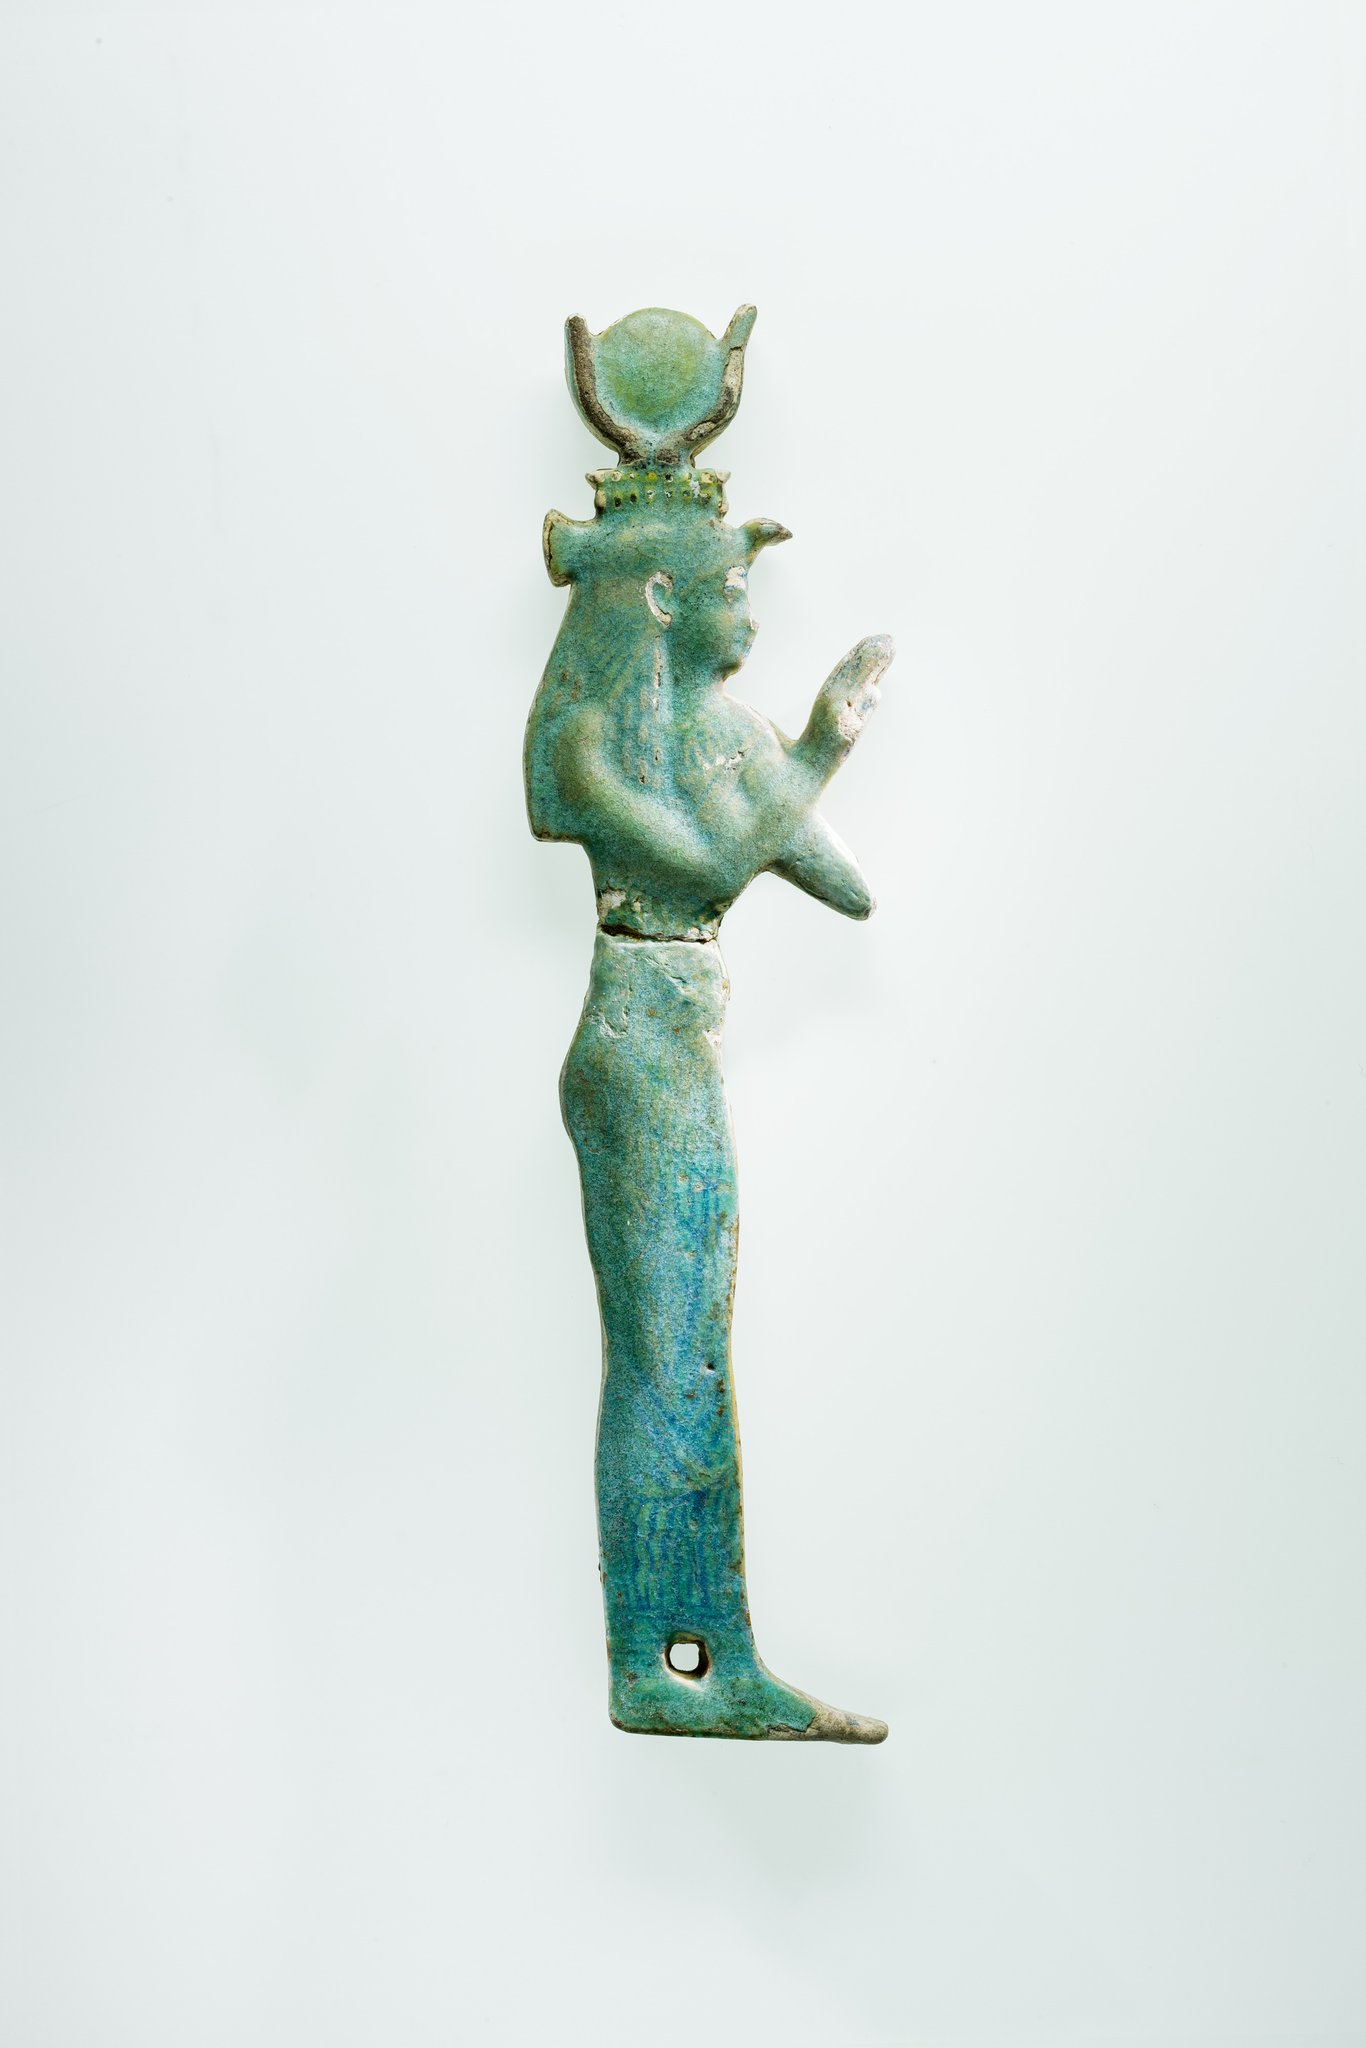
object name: inlay, isi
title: Inlay depicting the goddess Isis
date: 664-630 BCE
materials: faience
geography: egypt